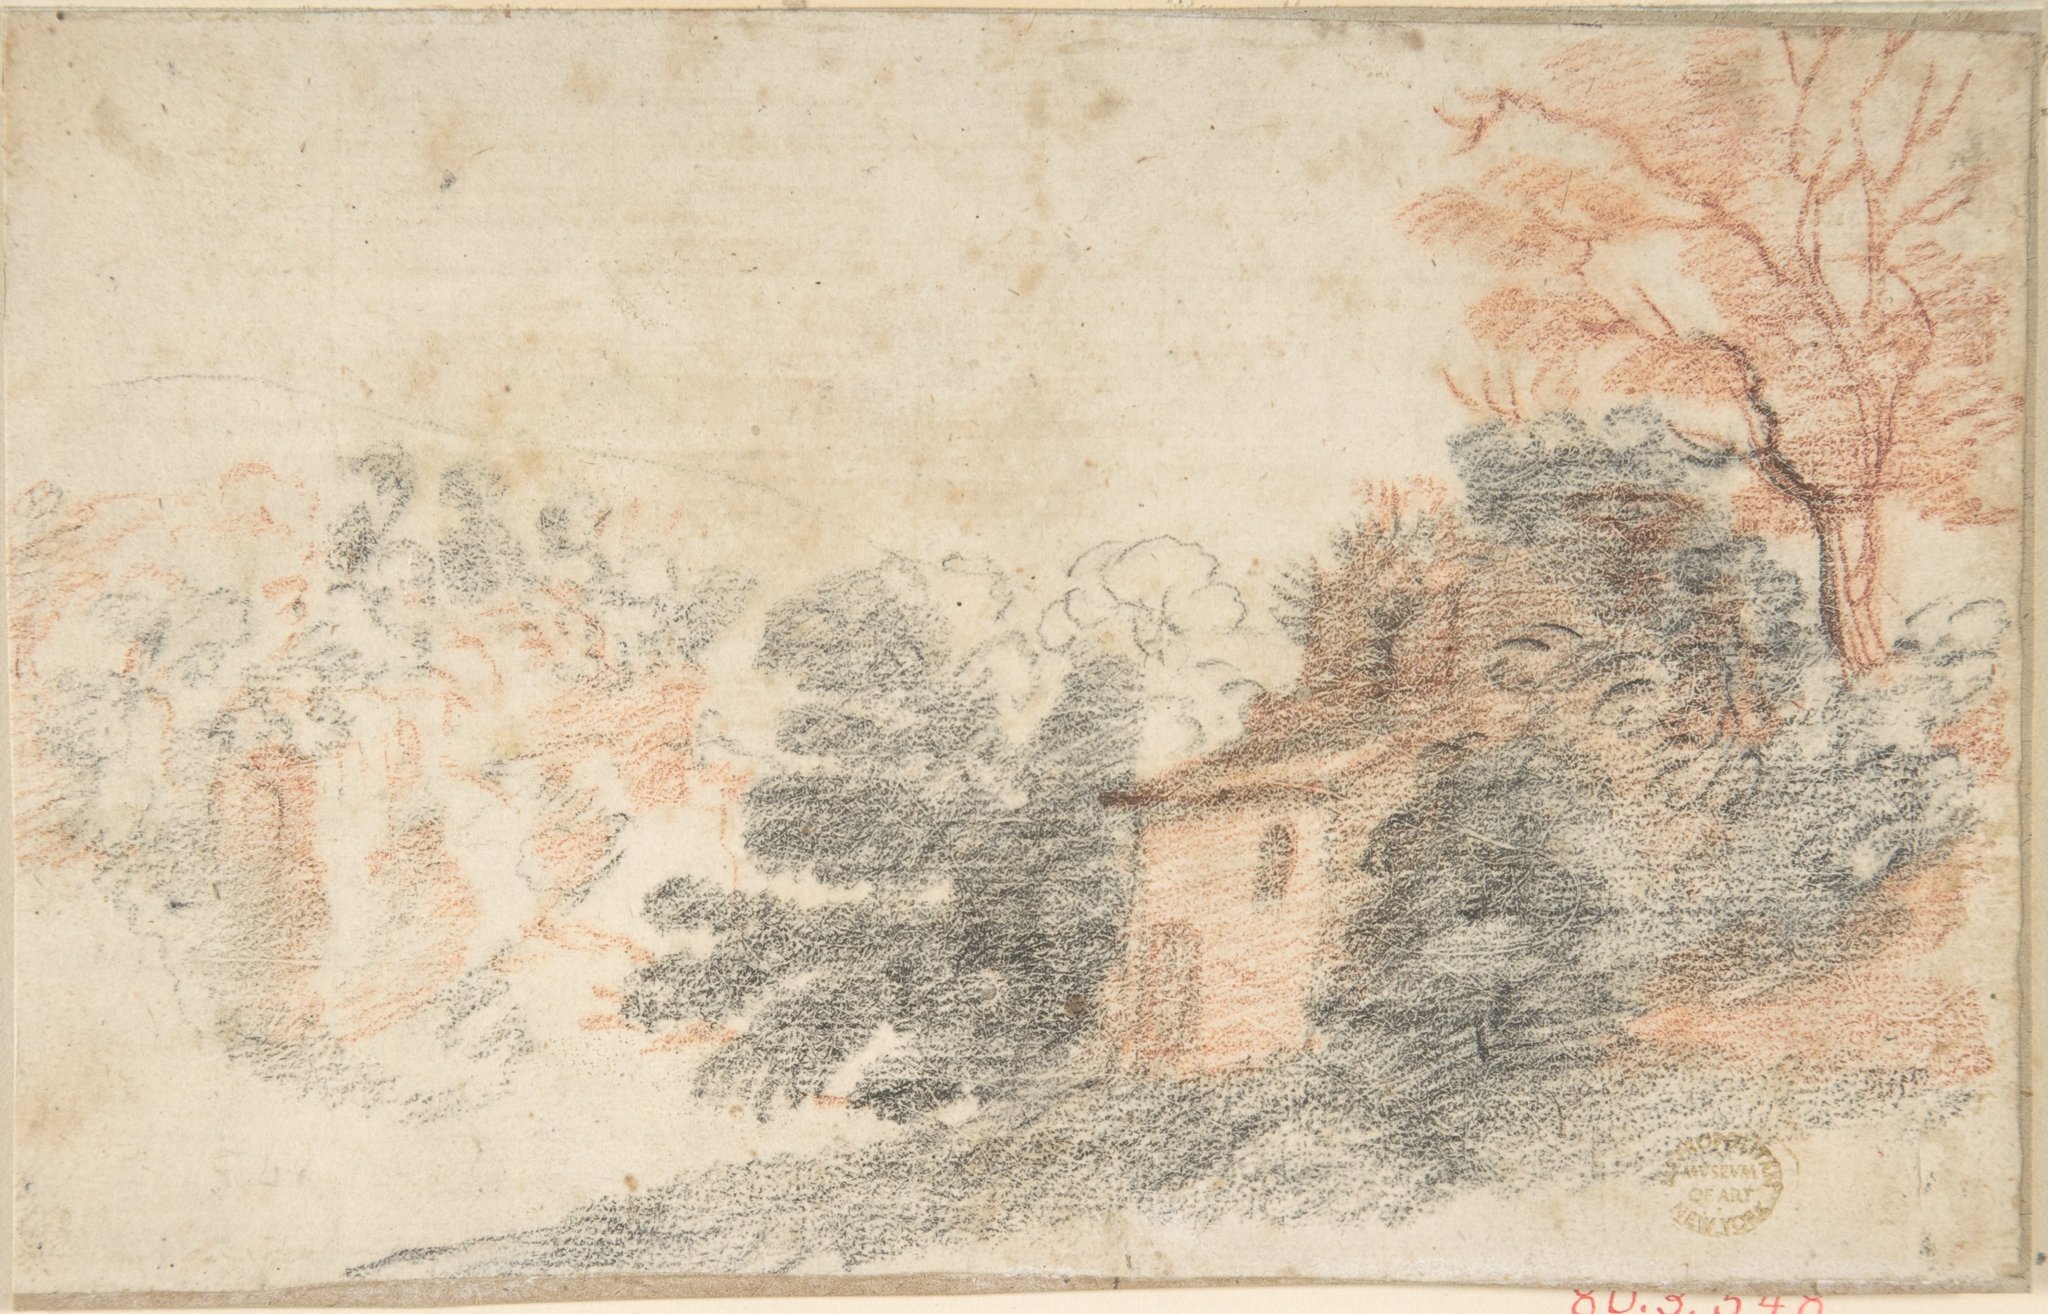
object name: drawing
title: Landscape with House and Trees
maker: anonymous, italian, roman-bolognese, 17th century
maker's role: artist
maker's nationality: italian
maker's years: 1600-1700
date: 1601-1700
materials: chalk, paper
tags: houses,landscapes,trees